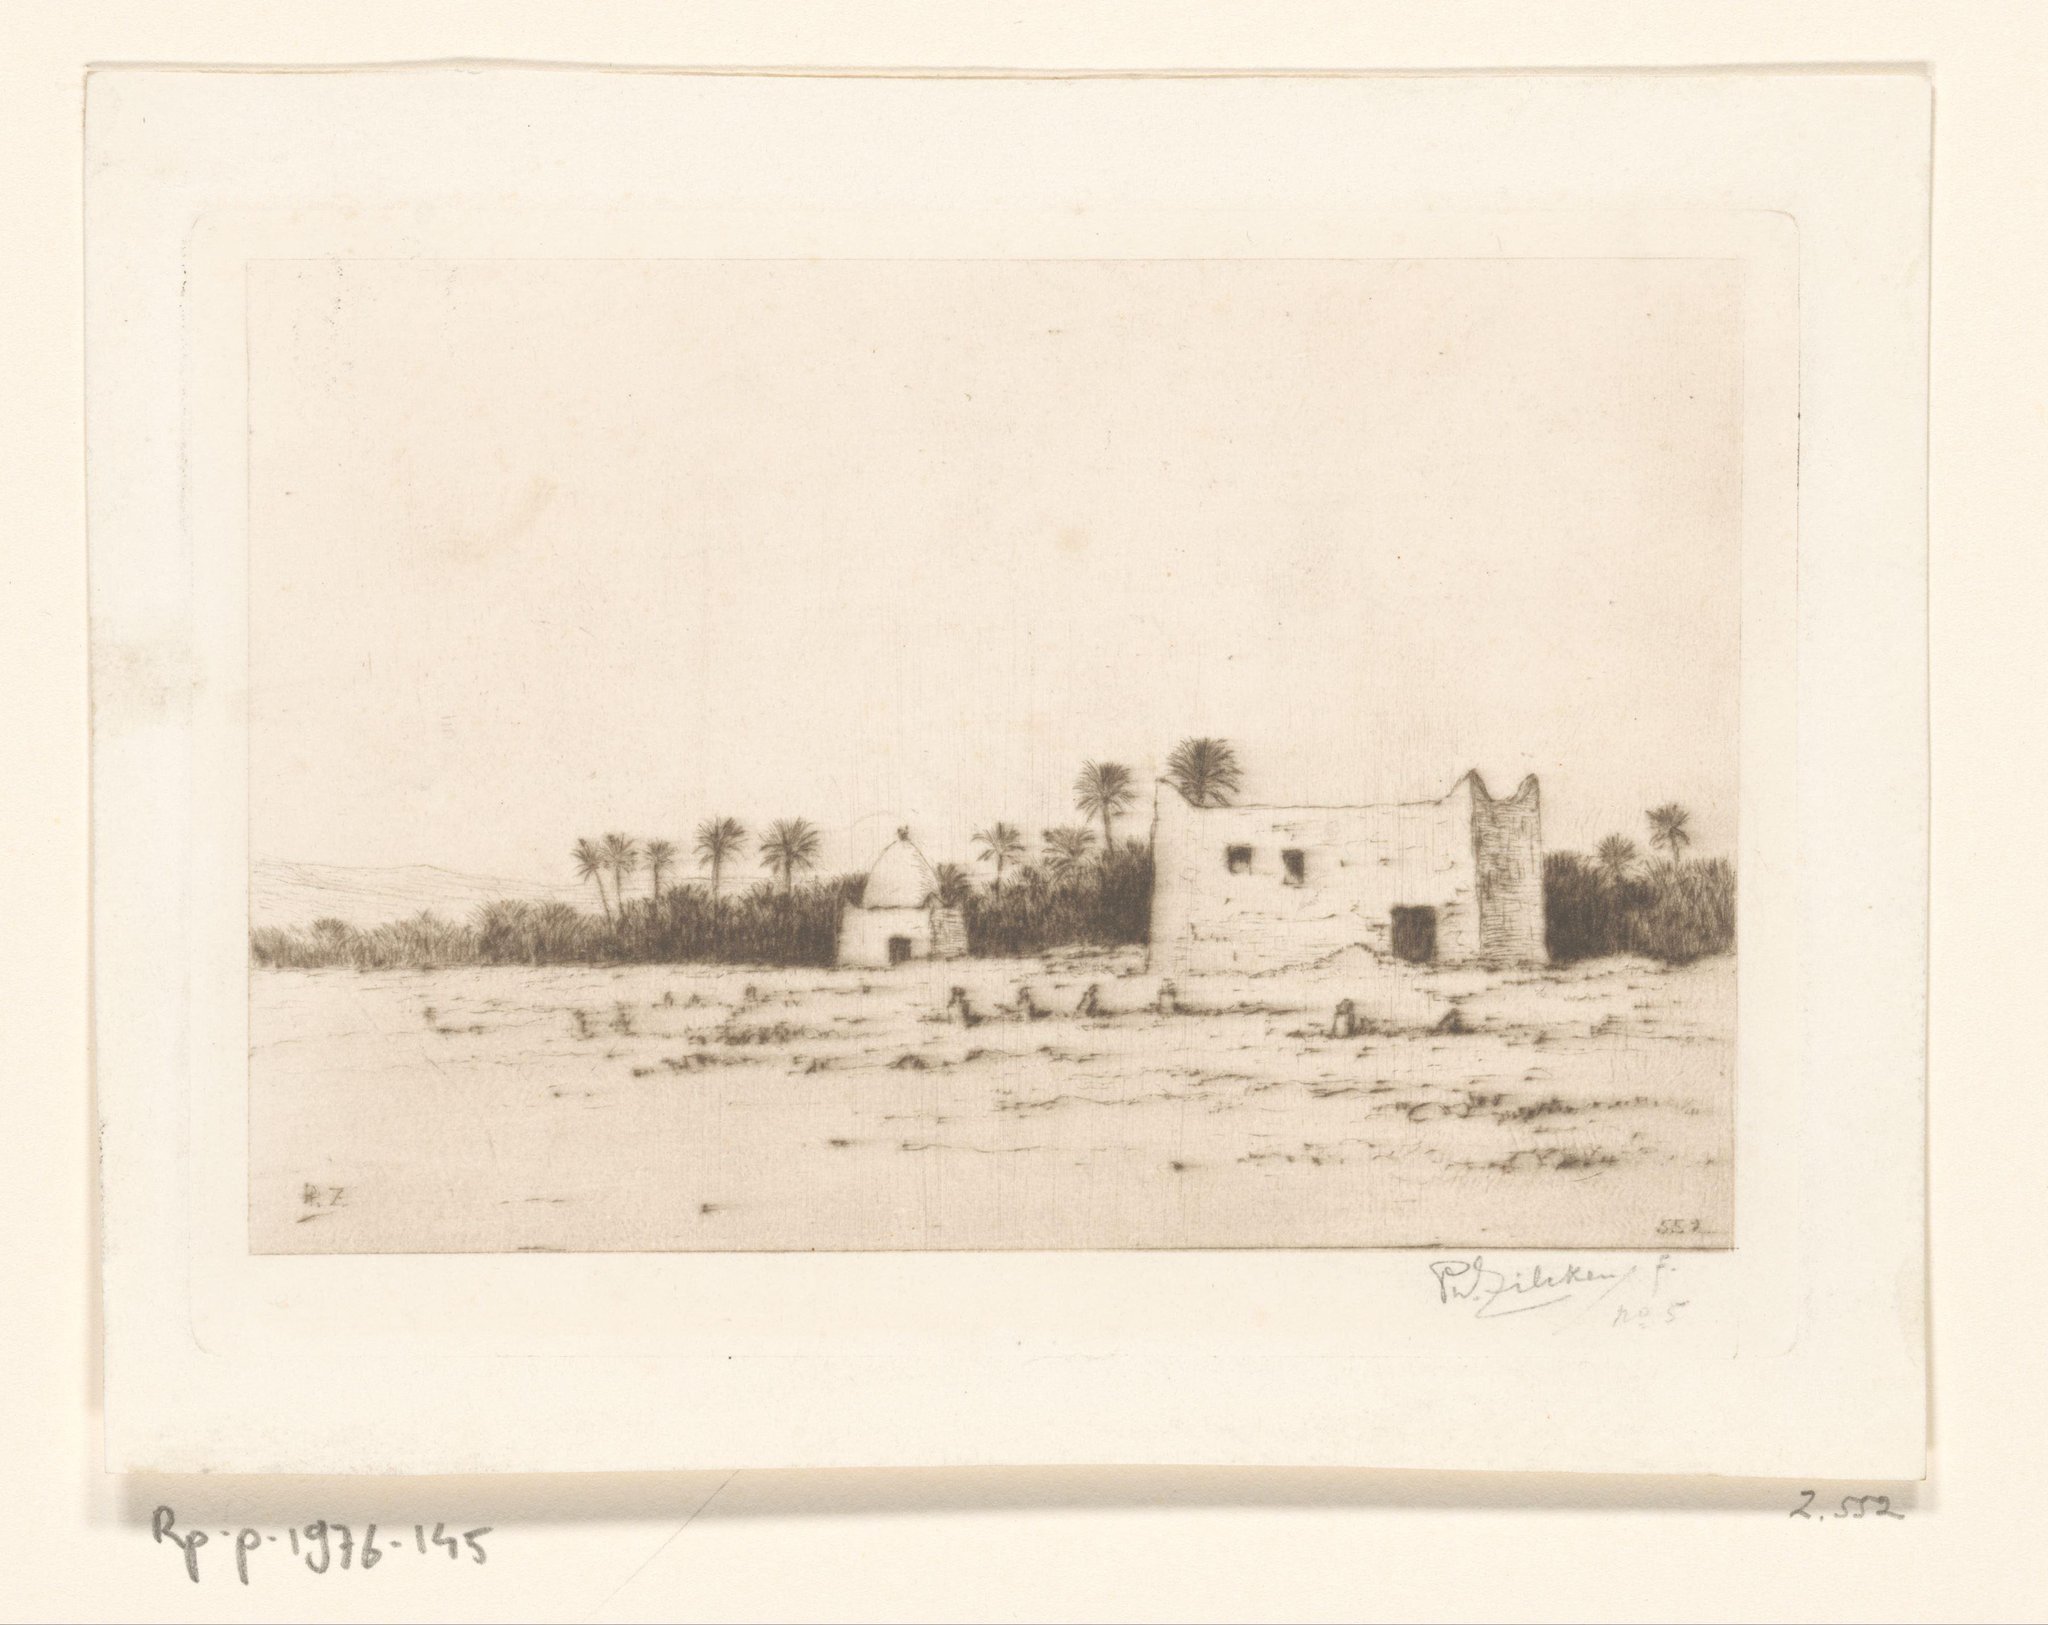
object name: print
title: Begraafplaats in een oase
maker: philip zilcken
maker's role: draughtsman, painter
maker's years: 1857-1930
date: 1890-1930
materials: paper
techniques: drypoint, intaglio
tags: oasis, churchyard, cemetery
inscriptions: collector's mark: Lugt 2228